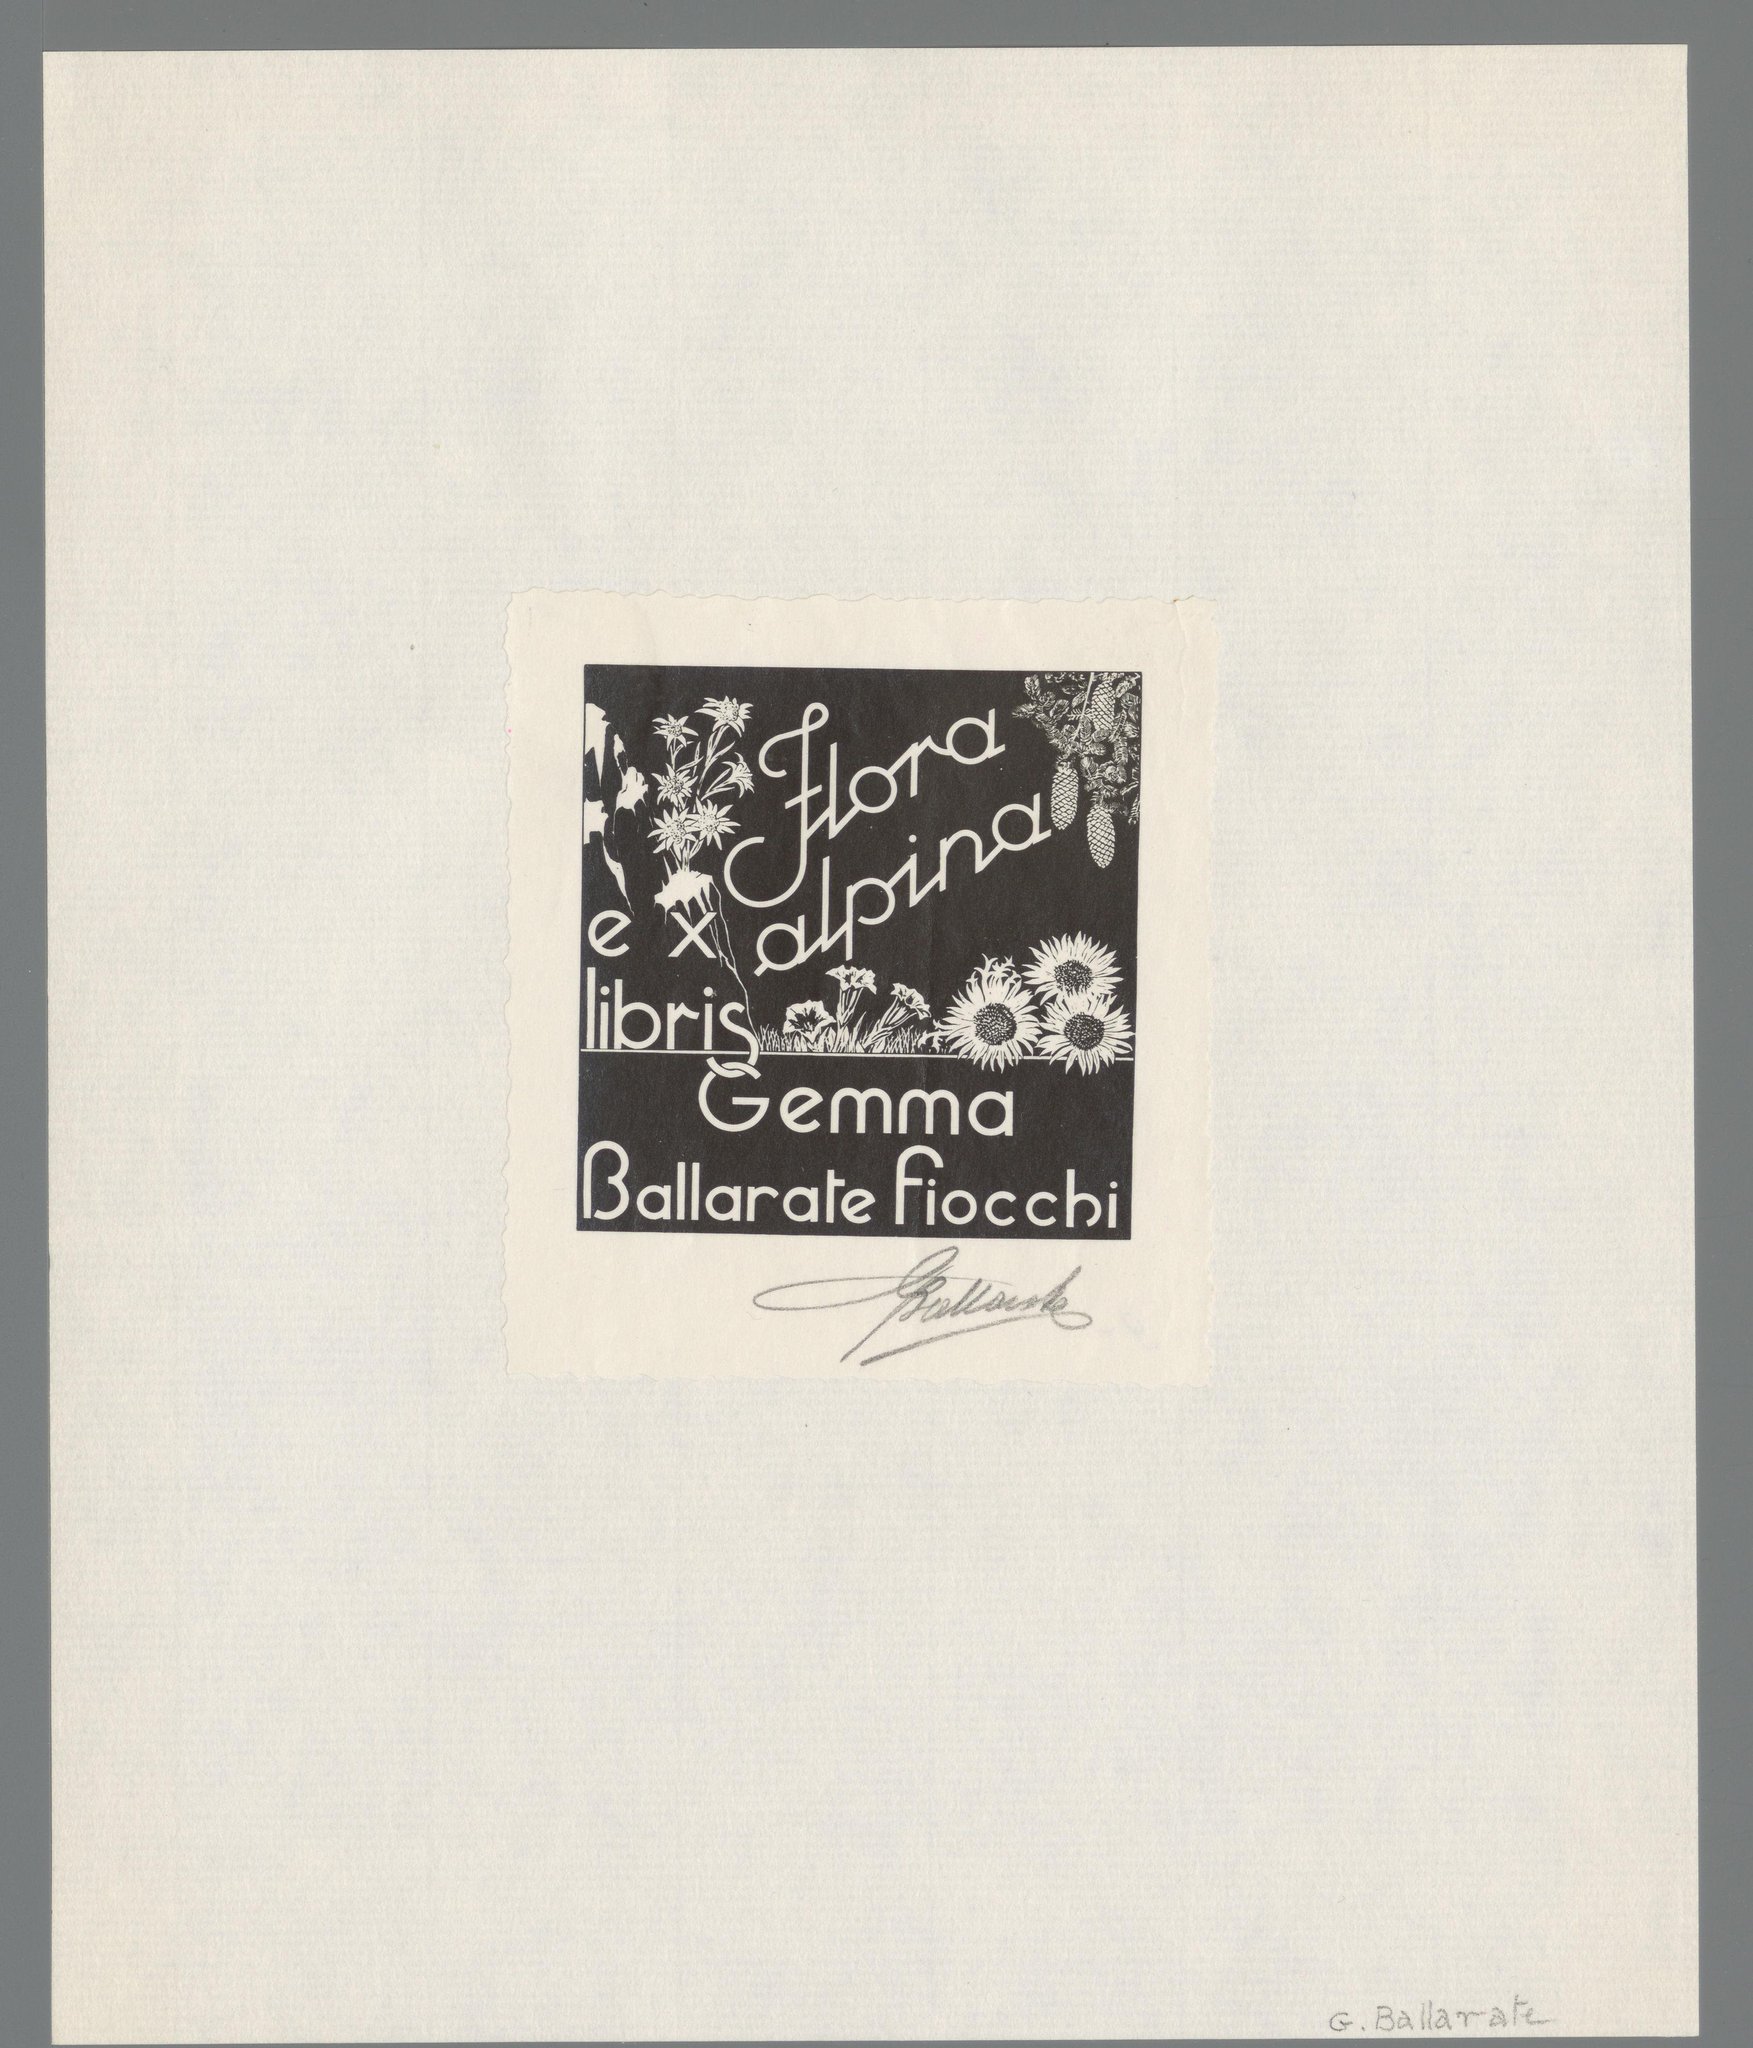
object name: bookplate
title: Ex libris van Gemma Ballarate Fiocchi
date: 1930-1960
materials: paper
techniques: printing block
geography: italy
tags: gemma ballarate fiocchi, flowers, fruits: pine-cone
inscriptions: number: ‘9-’, signature: ‘G Ballarate’